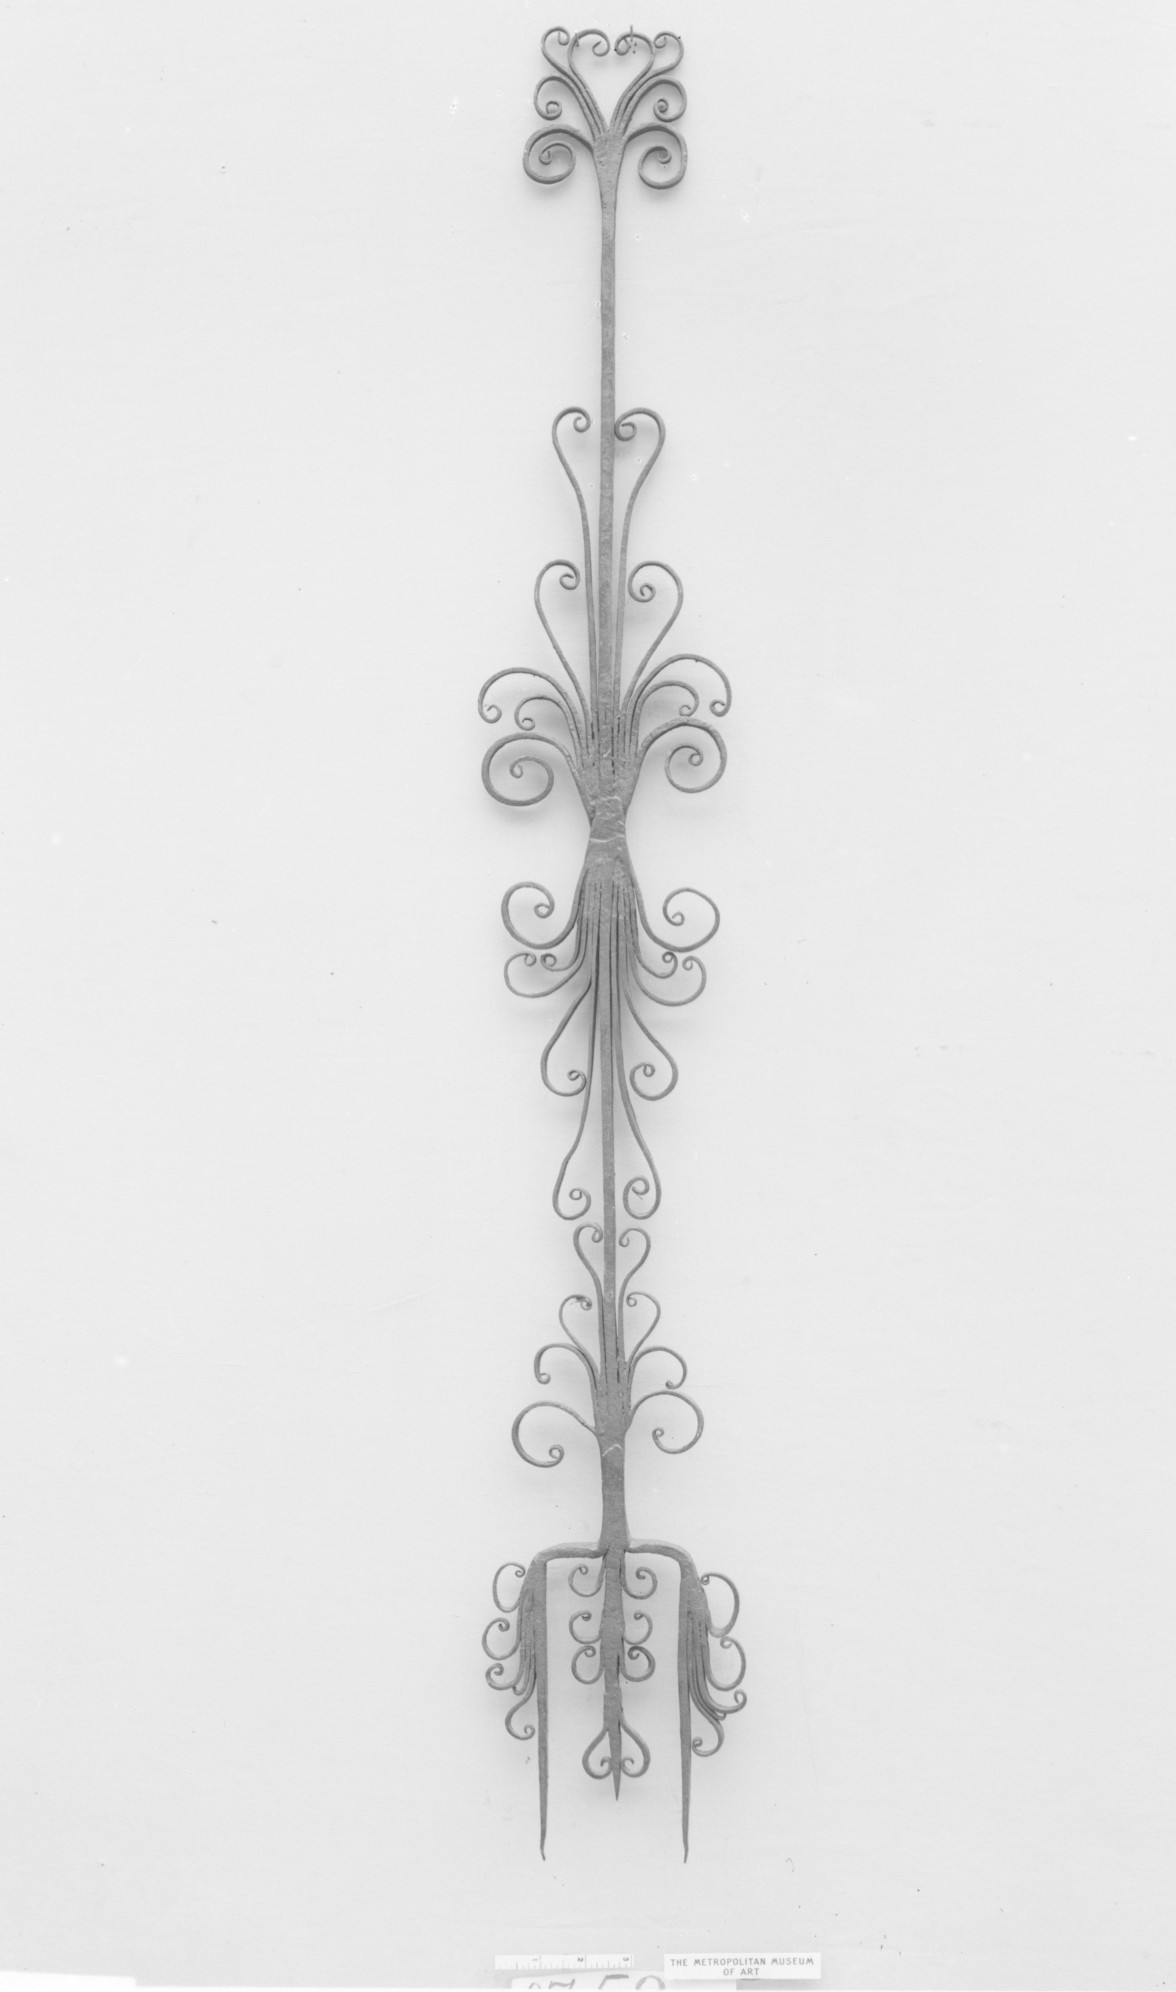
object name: fork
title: Broaching or toasting fork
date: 1601-1700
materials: iron